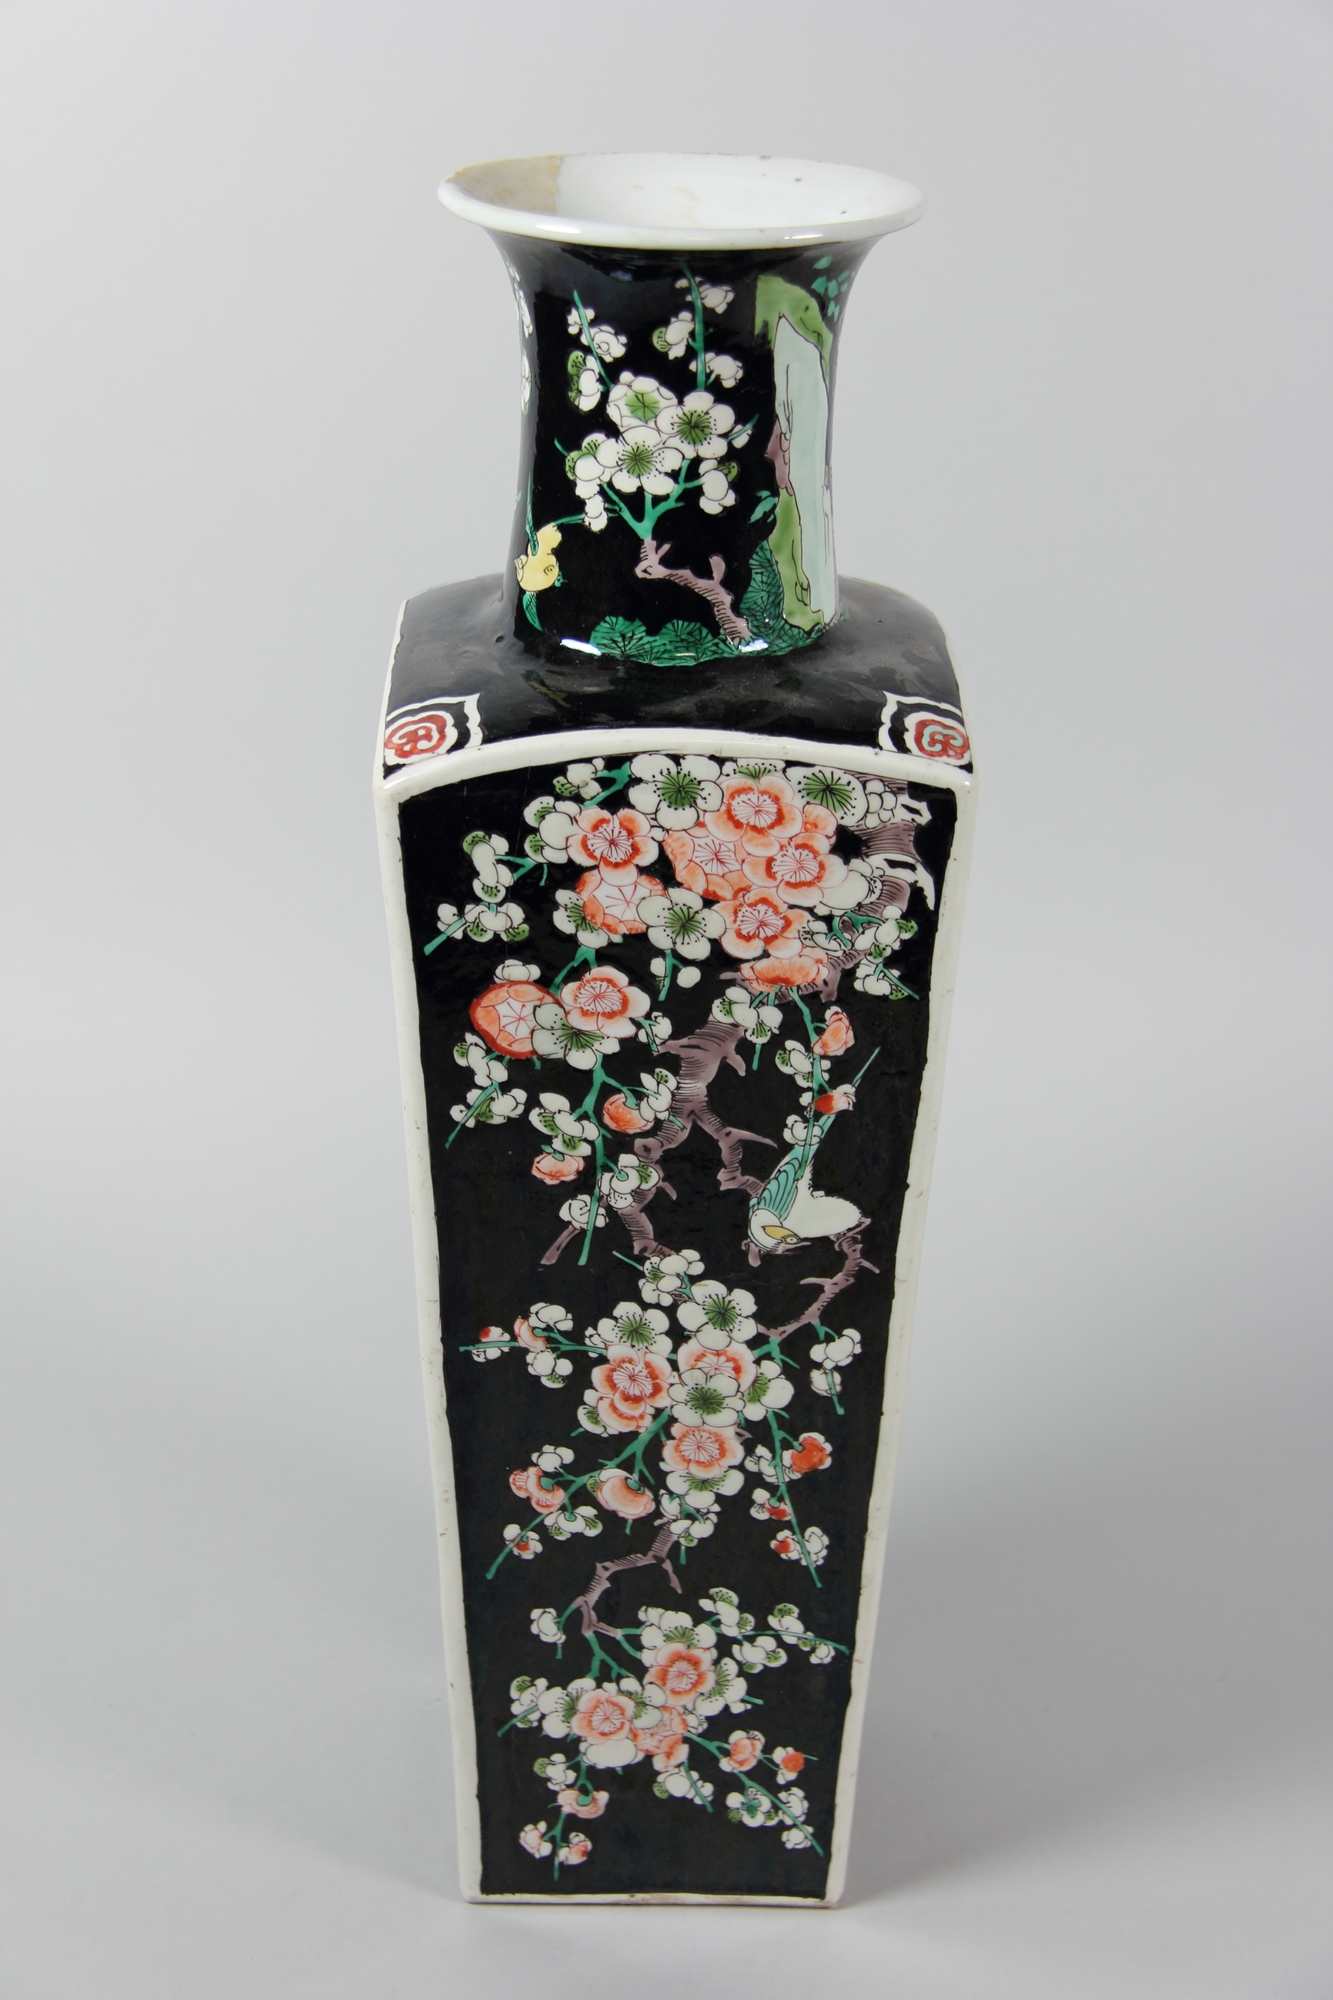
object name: vase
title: Square vase with birds and flowers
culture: chinese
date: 1801-1900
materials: enamel, porcelain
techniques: painting, polychrome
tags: flowers